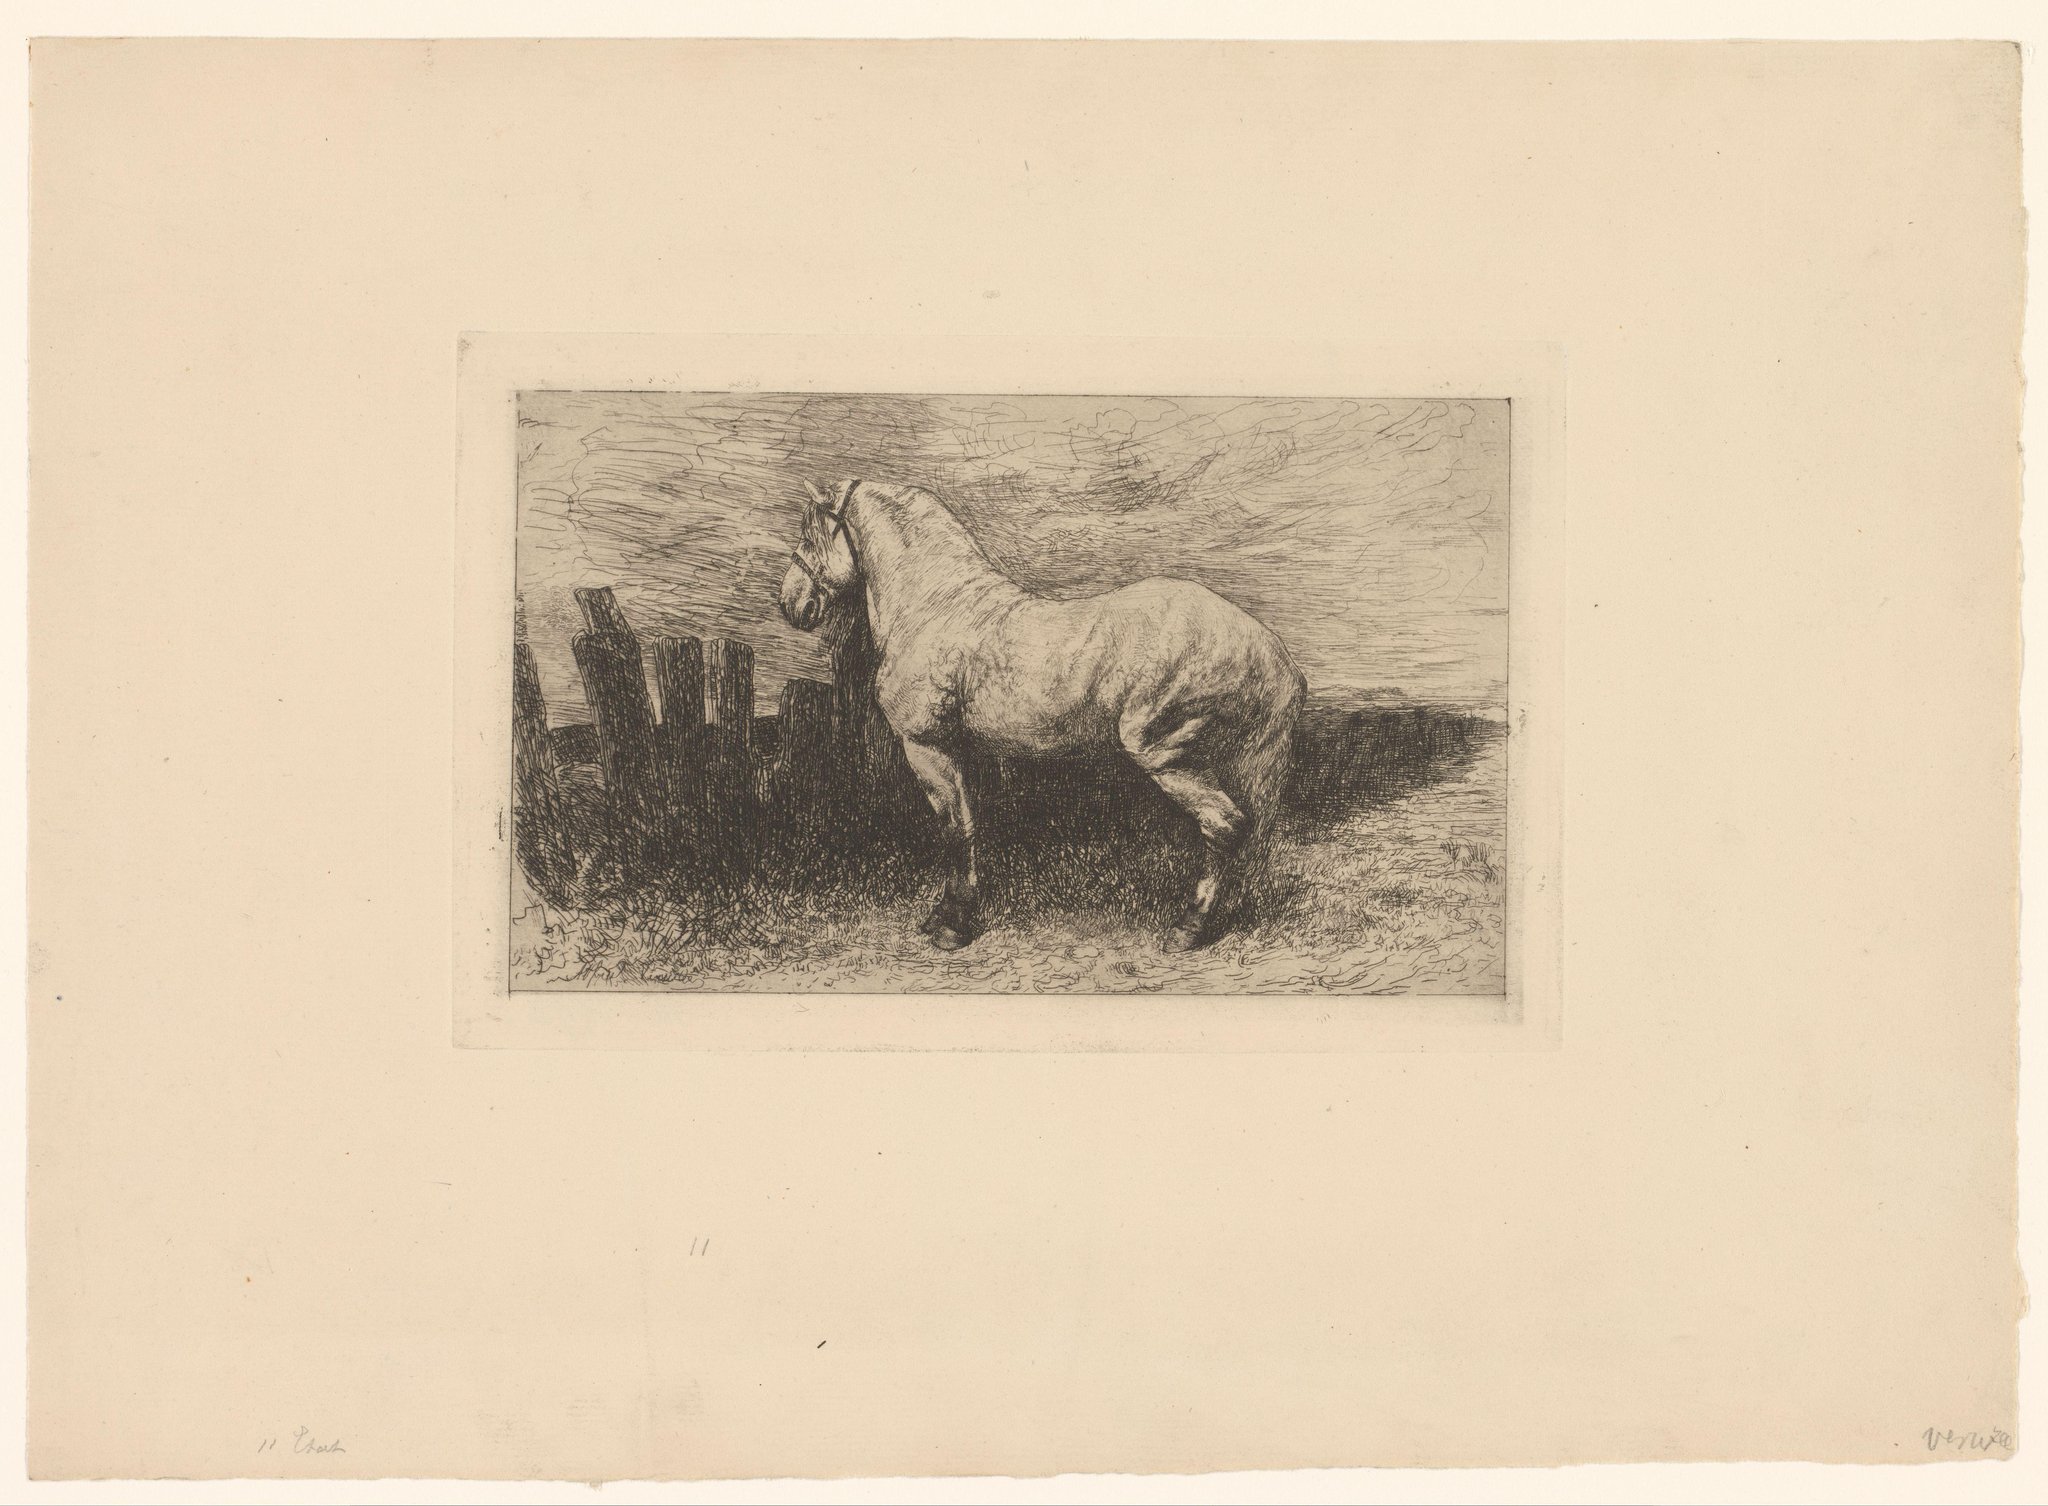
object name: print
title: Paard met halster bij een hek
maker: alfred verwee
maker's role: print maker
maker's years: 1838-1895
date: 1848-1895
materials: paper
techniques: etching, intaglio, retroussage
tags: horses and kindred animals, fence, wall, paling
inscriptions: inscription: ‘II Etat’, collector's mark: Lugt 2228